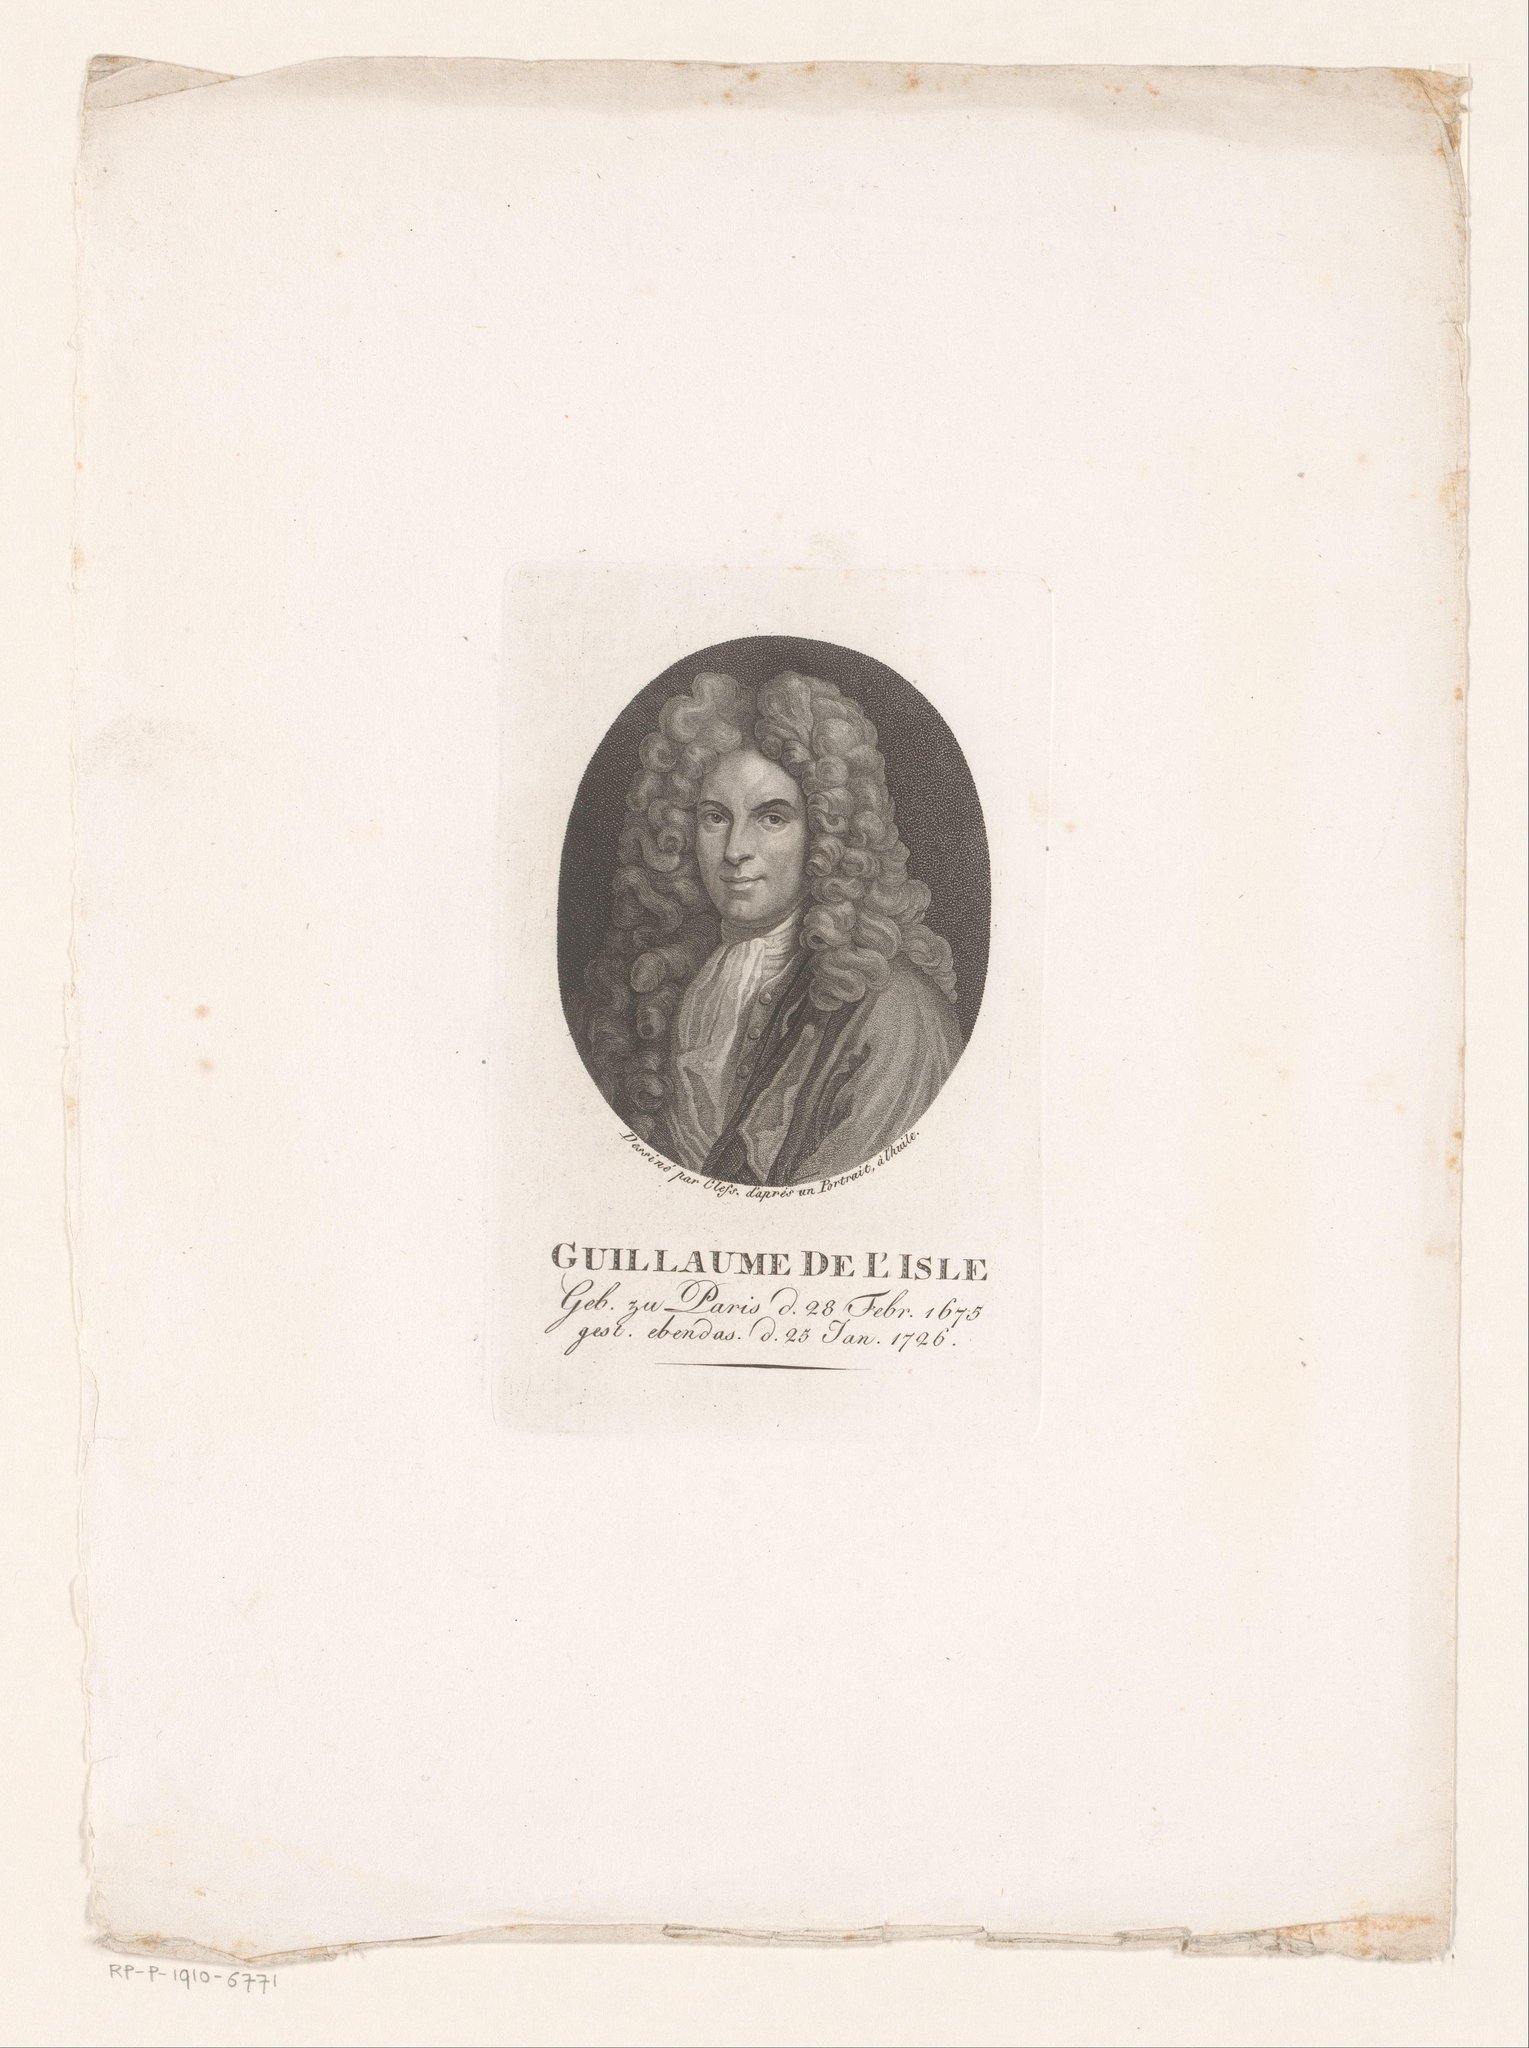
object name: print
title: Portret van Guillaume Delisle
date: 1784-1834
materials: paper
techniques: engraving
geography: germany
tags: paris, guillaume delisle, historical persons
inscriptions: collector's mark: Lugt 2228